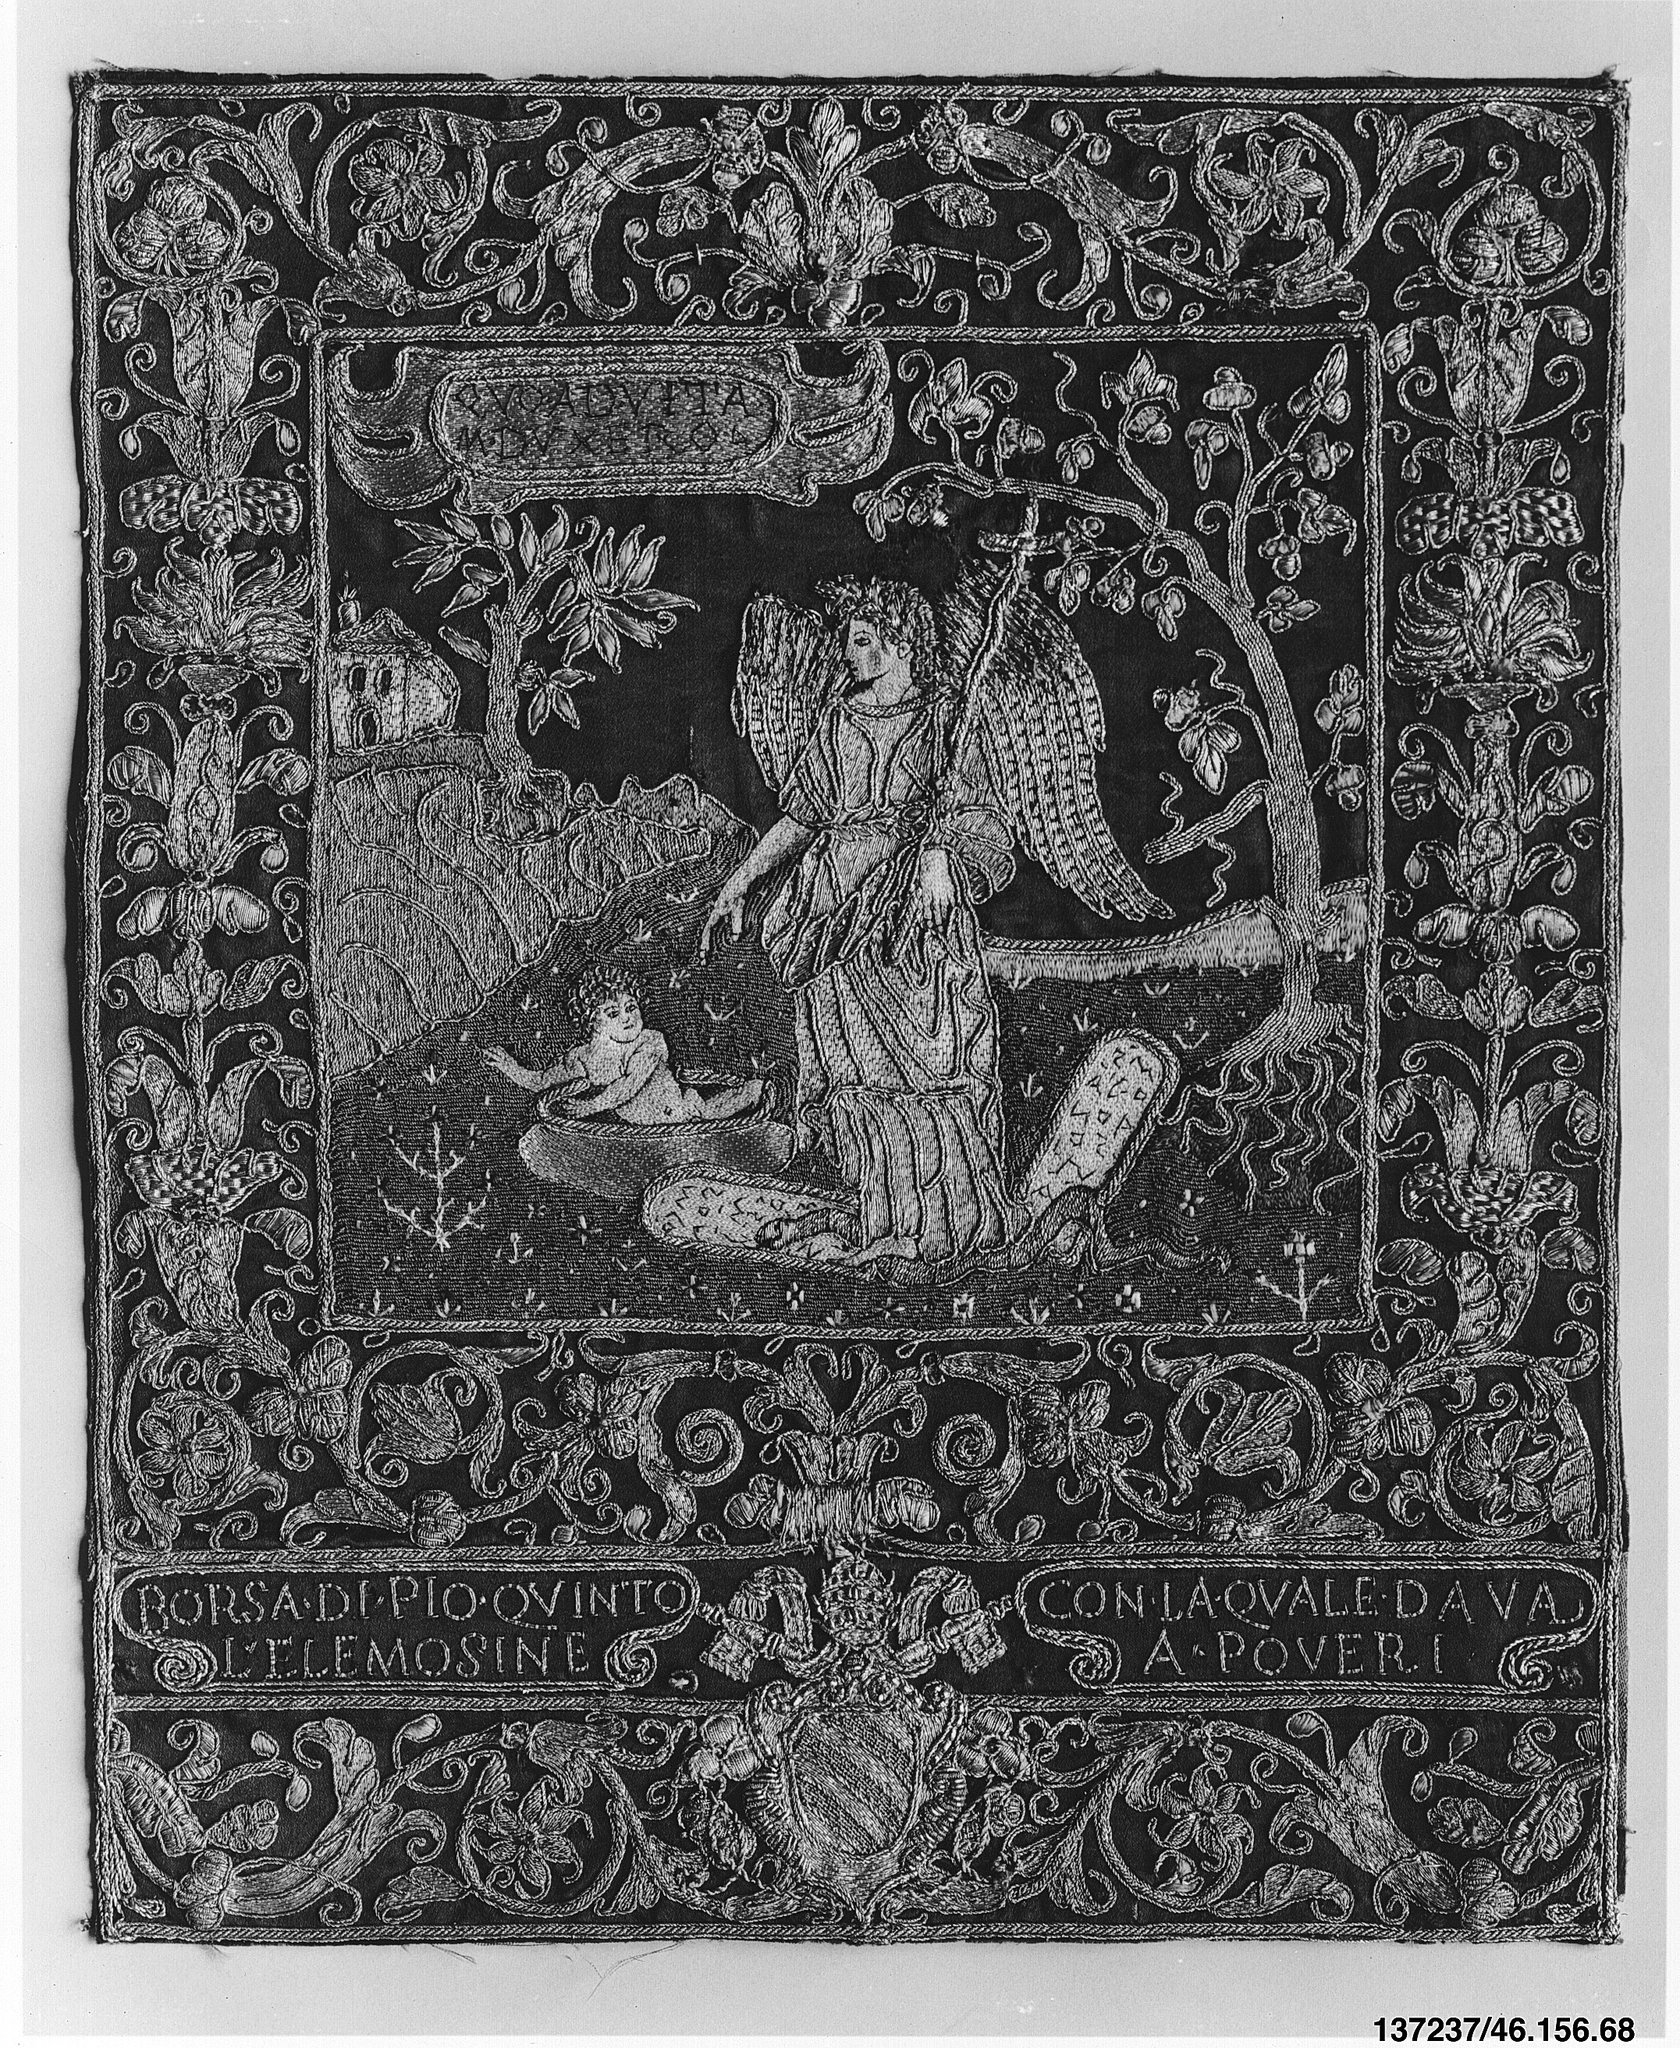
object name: panel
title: Triumph of the Church over the Synagogue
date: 1566-1572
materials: metal thread, silk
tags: children,angels